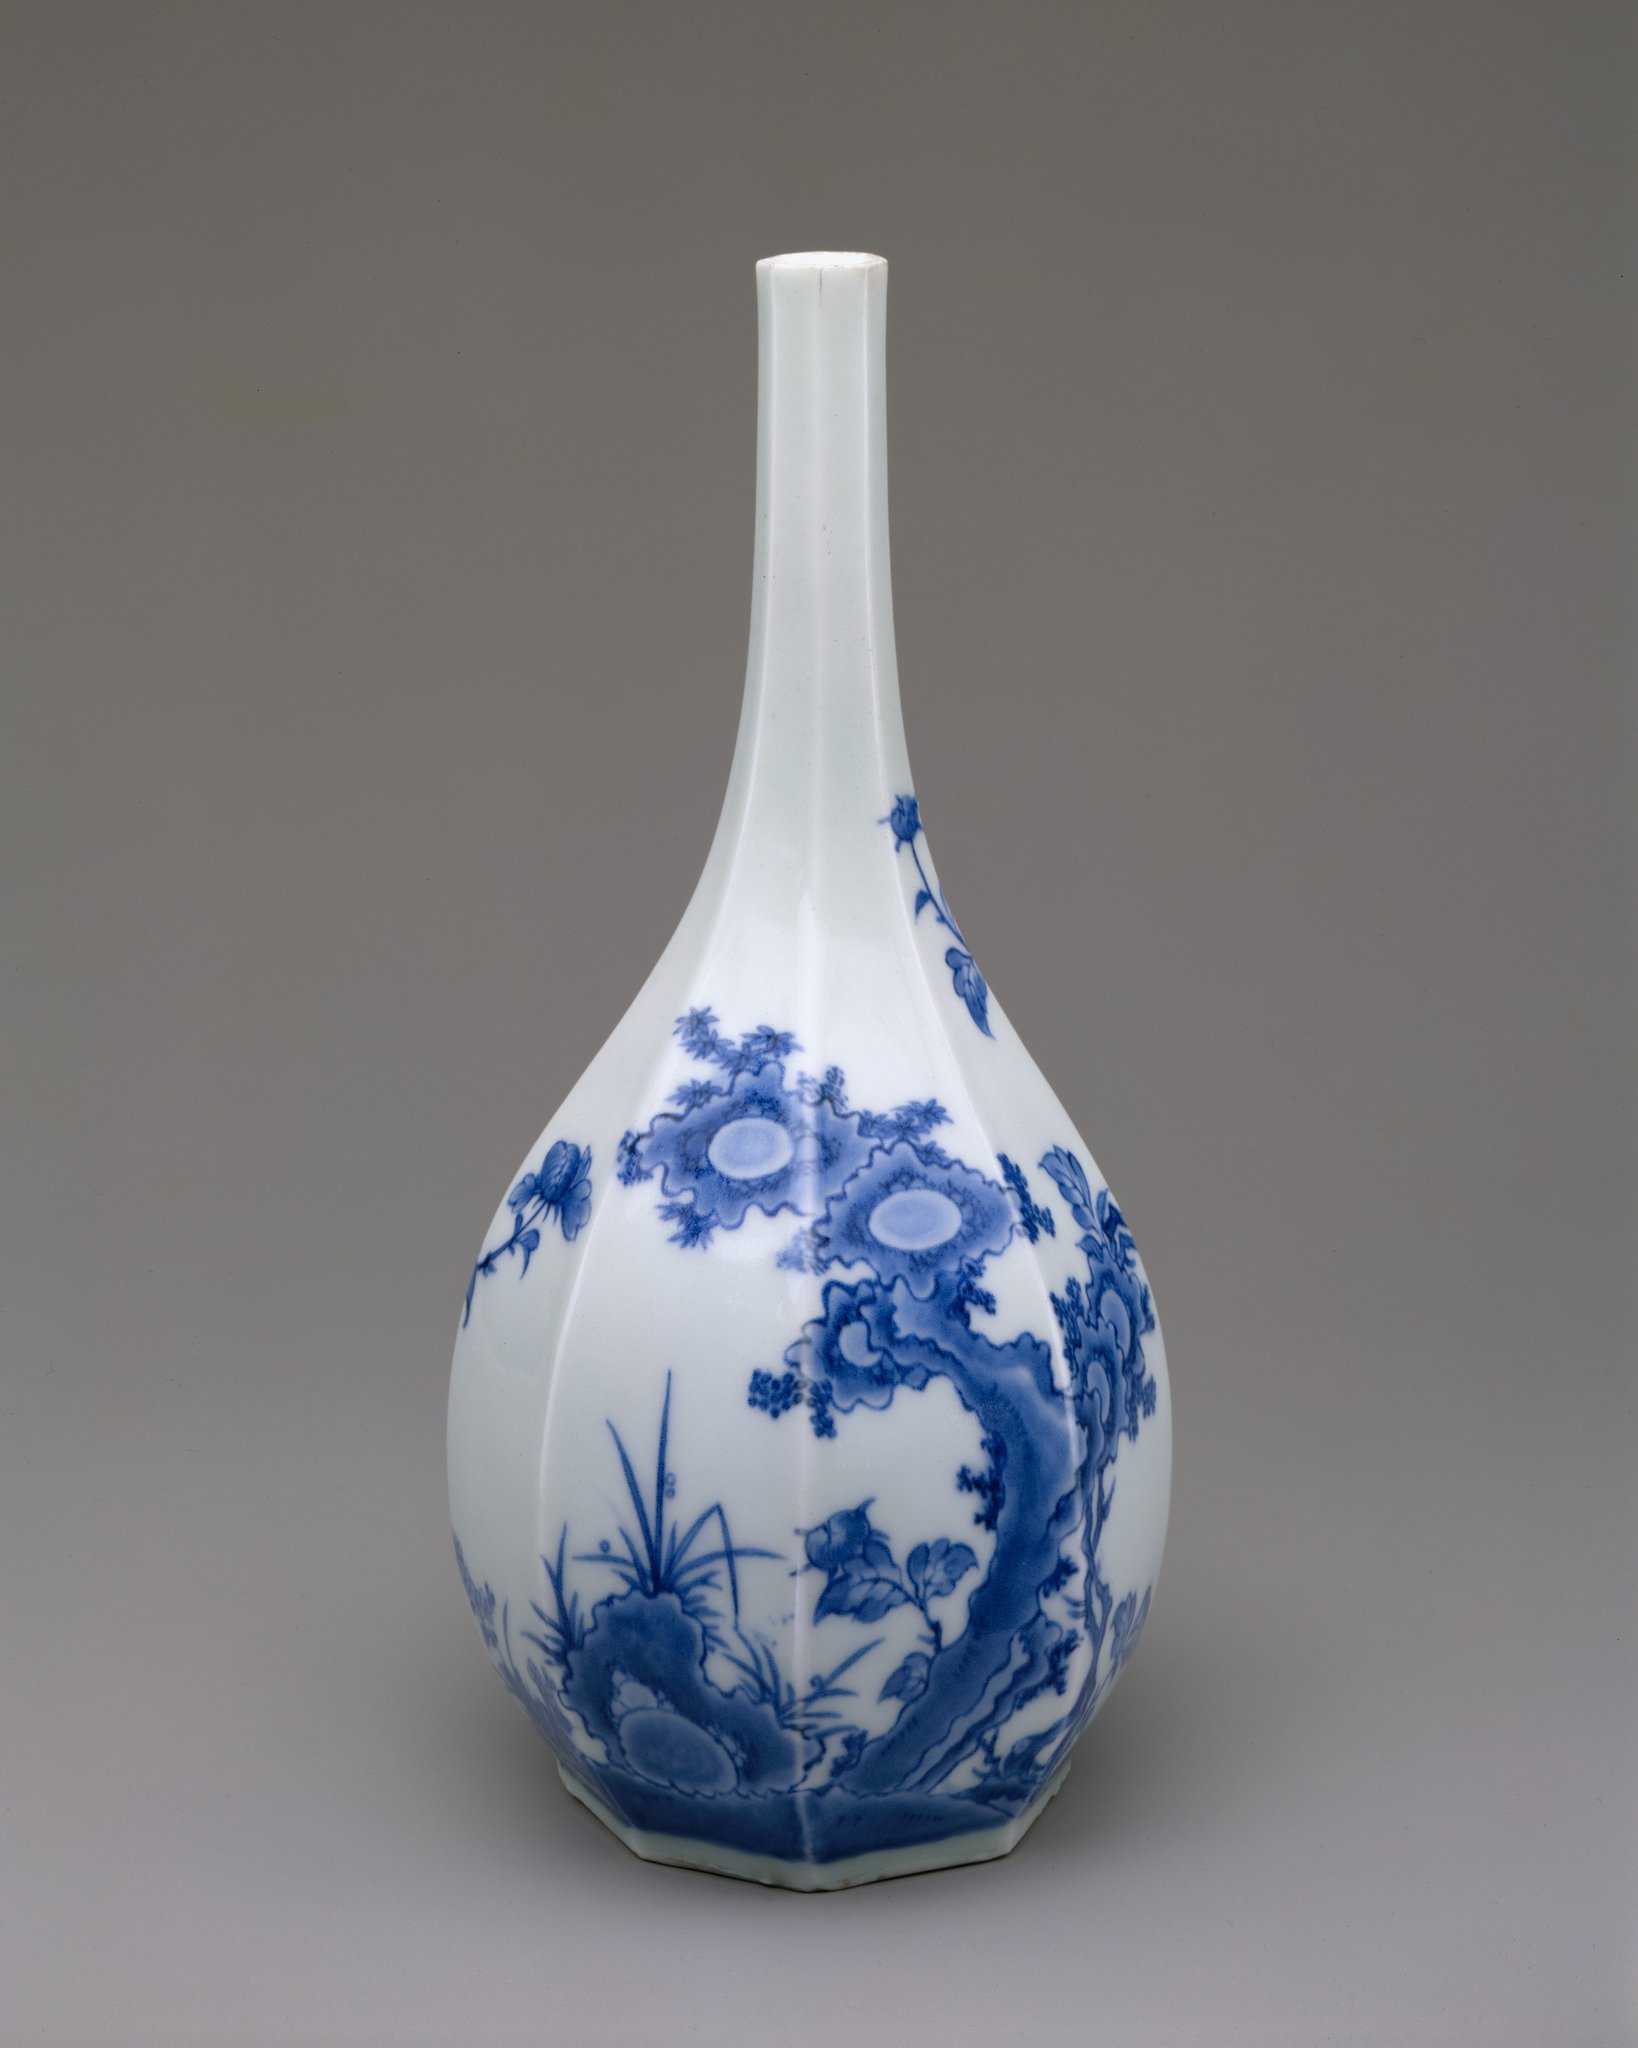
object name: bottle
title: Bottle with Peony and Rock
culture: japanese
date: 1701-1800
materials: porcelain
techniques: underglaze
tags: peonies